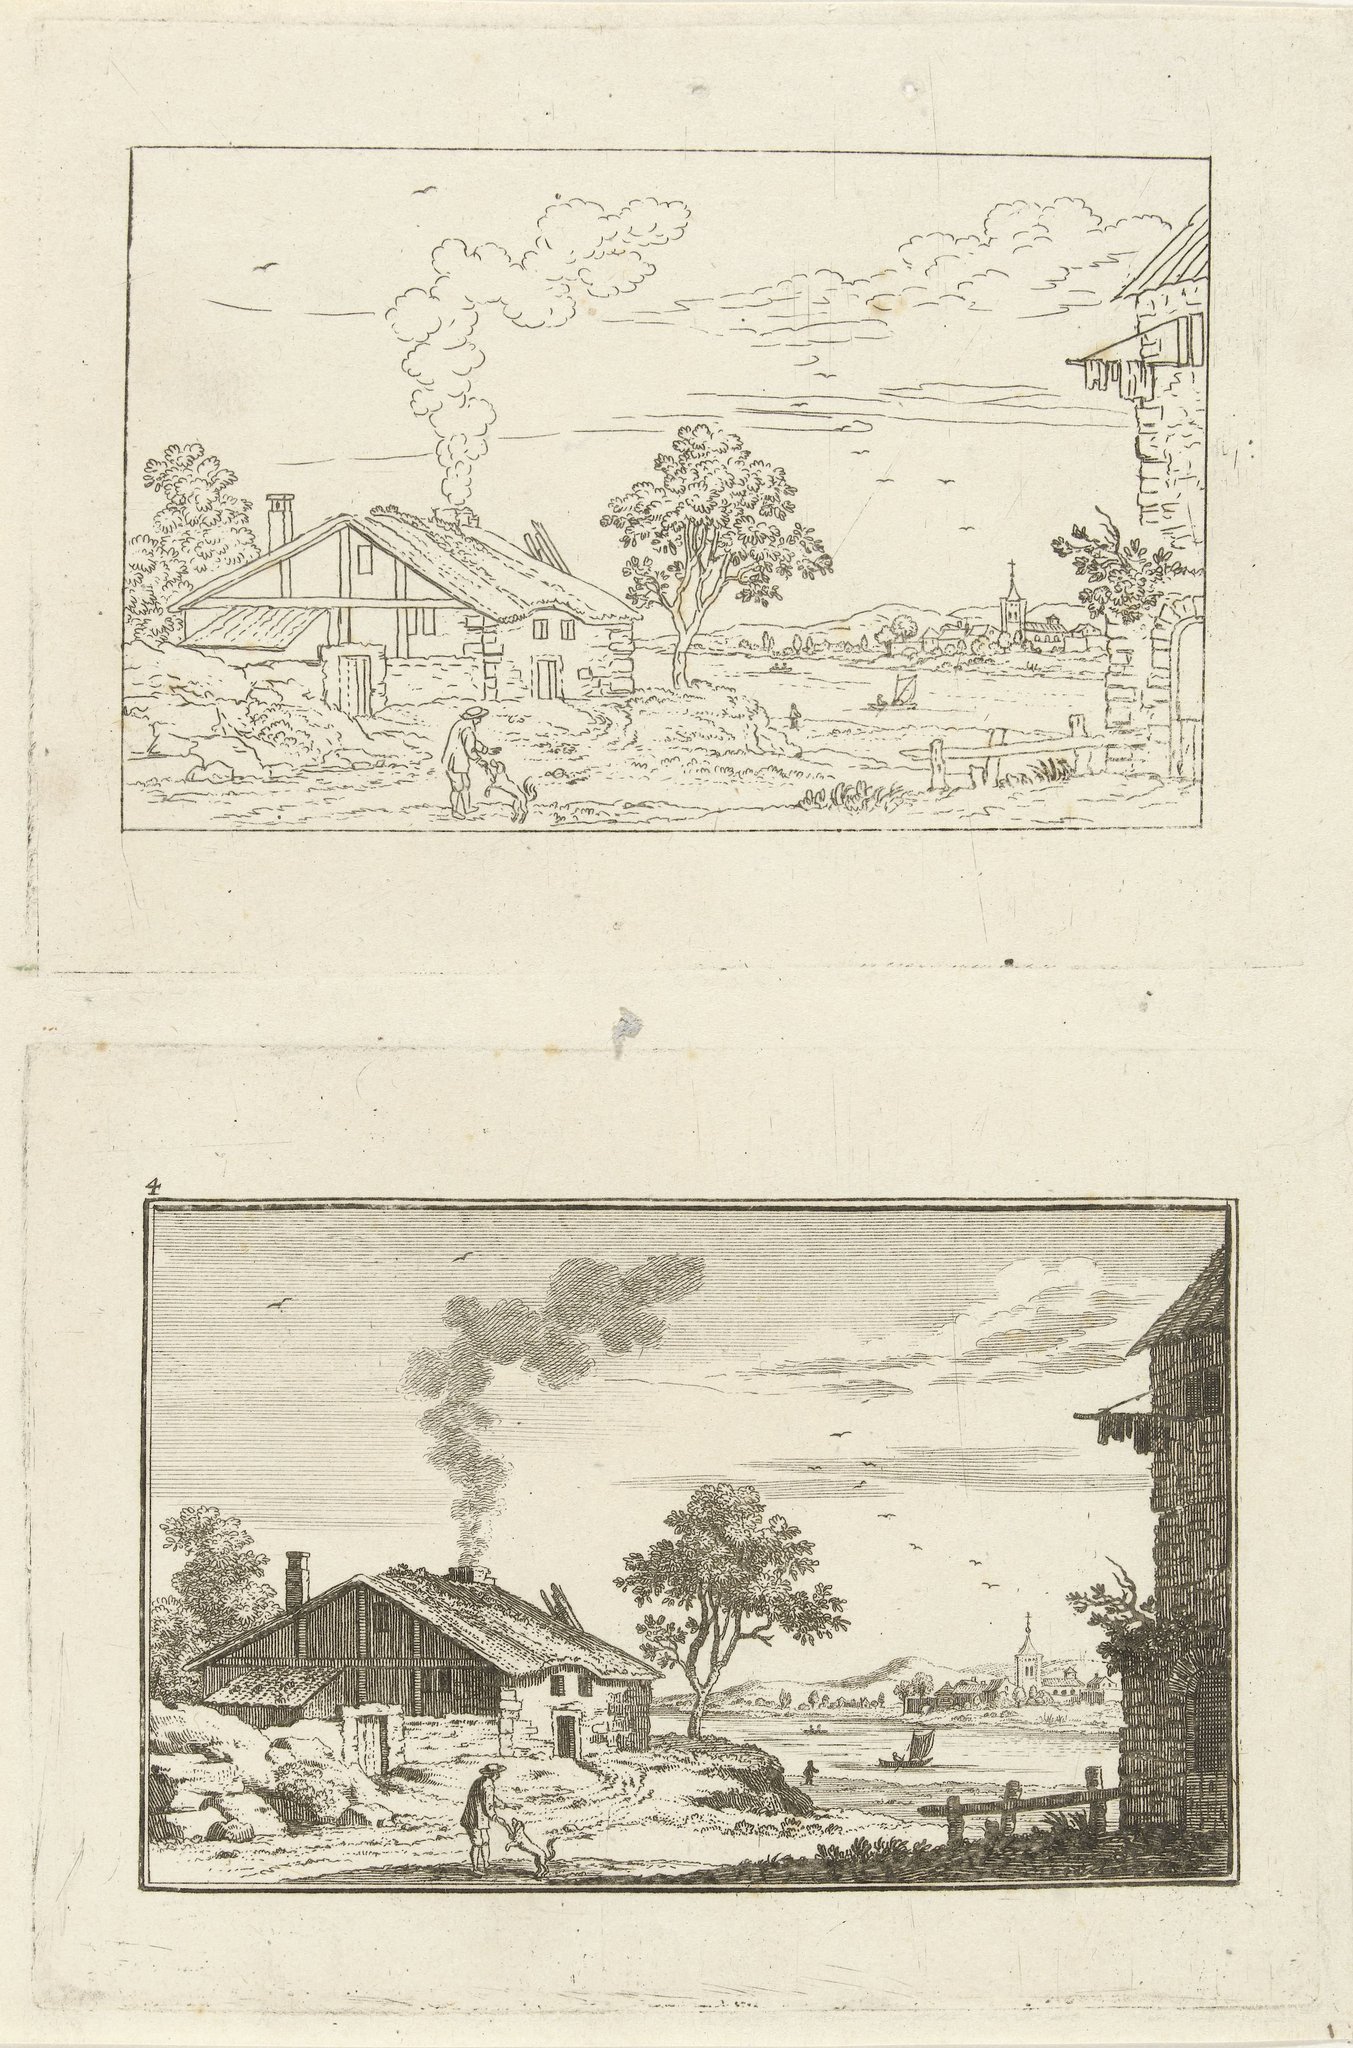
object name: print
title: Landschappen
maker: christian friedrich fritzsch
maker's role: print maker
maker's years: 1719-1774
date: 1729-1774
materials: paper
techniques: etching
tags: landscapes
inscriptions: collector's mark: Lugt 2228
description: Twee dezelfde landschappen boven elkaar met links een huis en rechts een rivier. Op de voorgrond staat een man met hond, rechts is nog net een deel van een tweede huis te zien. Het bovenste landschap betreft een nog uit te werken prent, het onderste landschap is afgemaakt. Gedrukt van twee platen, de onderste prent is linksboven met een 4 genummerd.